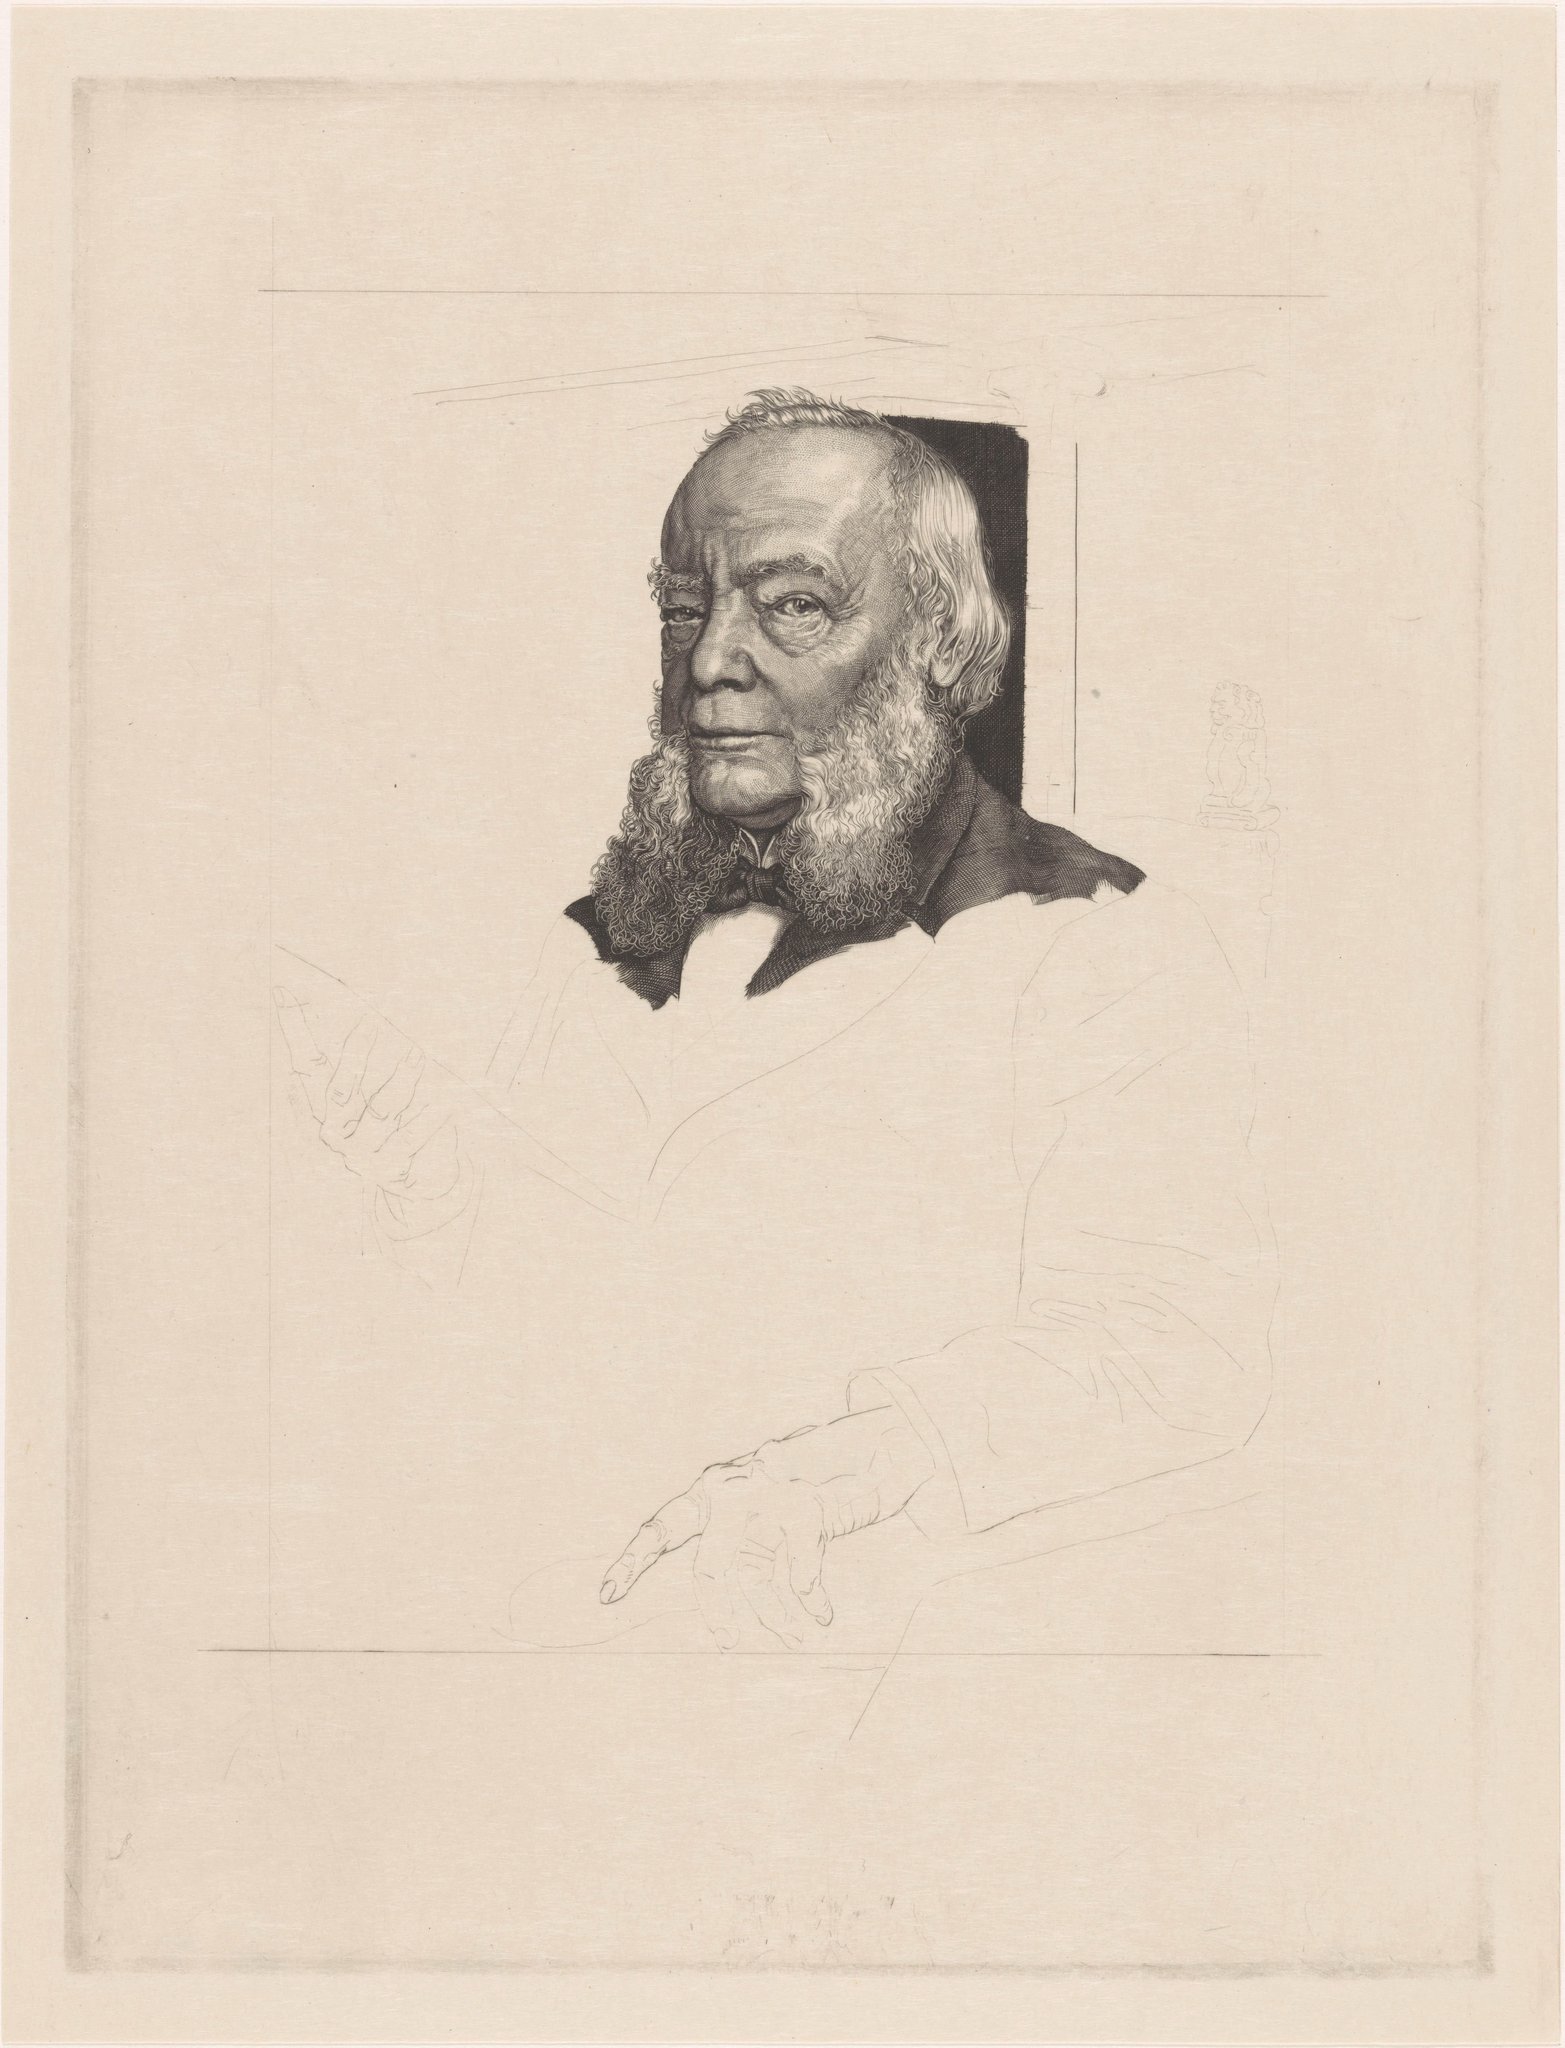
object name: print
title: Portret van Dirk Christiaan Meijer jr.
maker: pieter dupont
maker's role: draughtsman, print maker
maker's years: 1870-1911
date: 1908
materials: paper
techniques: engraving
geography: amsterdam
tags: dirk christiaan meijer jr., historical persons, art collector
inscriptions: collector's mark: Lugt 2233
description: Portret van de oudheidkundige, wijnhandelaar en antiekverzamelaar Dirk Christiaan Meijer jr., tevens mede-oprichter van het Genootschap Amstelodamum en penningmeester van het Koninklijk Oudheidkundige Genootschap. Op deze eerste staat van de prent is alleen het hoofd van Meijer voltooid.